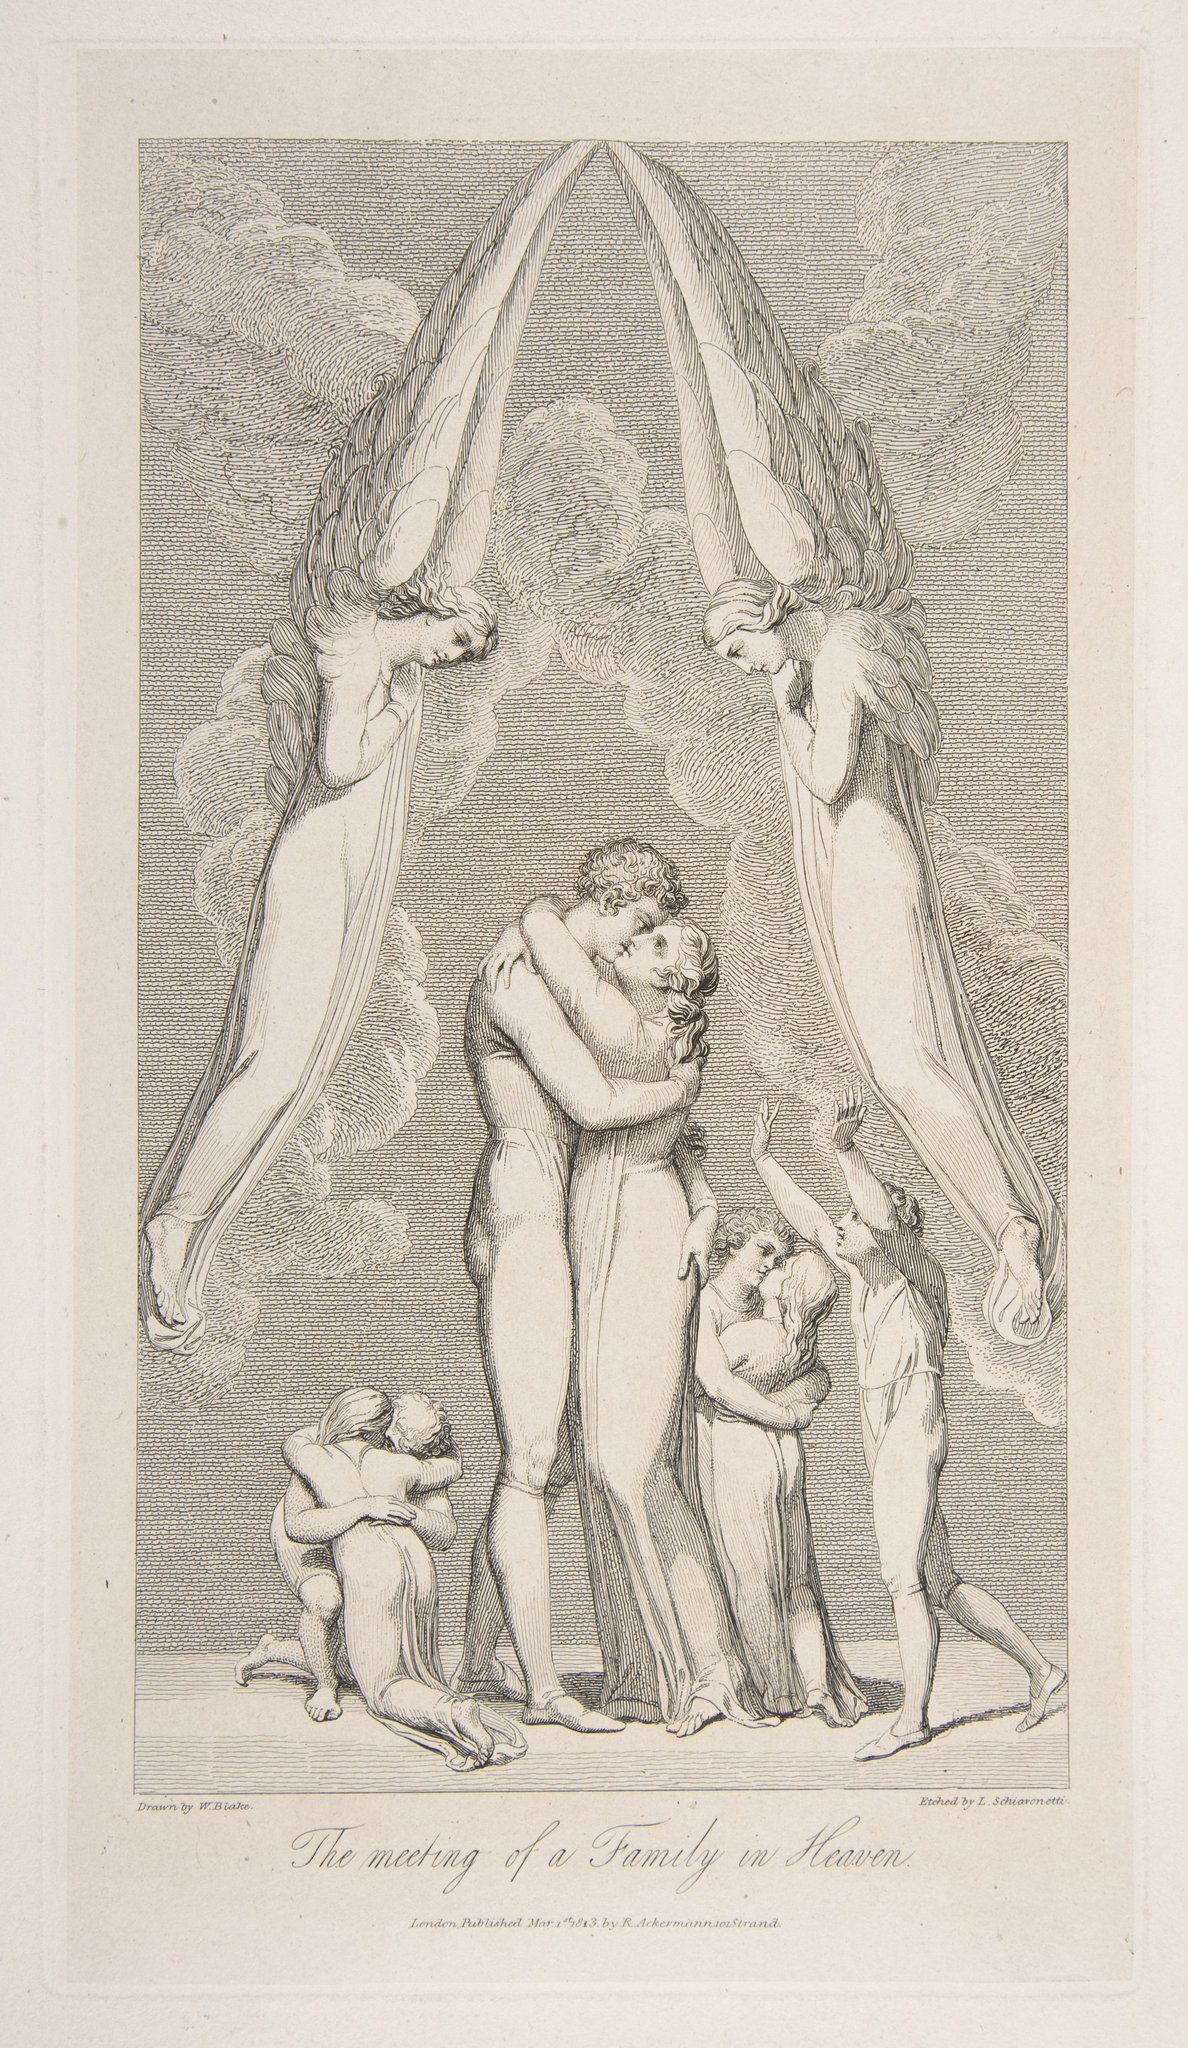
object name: print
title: The Meeting of a Family in Heaven, from "The Grave," a Poem by Robert Blair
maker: william blake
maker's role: artist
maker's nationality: british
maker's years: 1757-1827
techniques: engraving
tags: men,women,angels,heaven,family